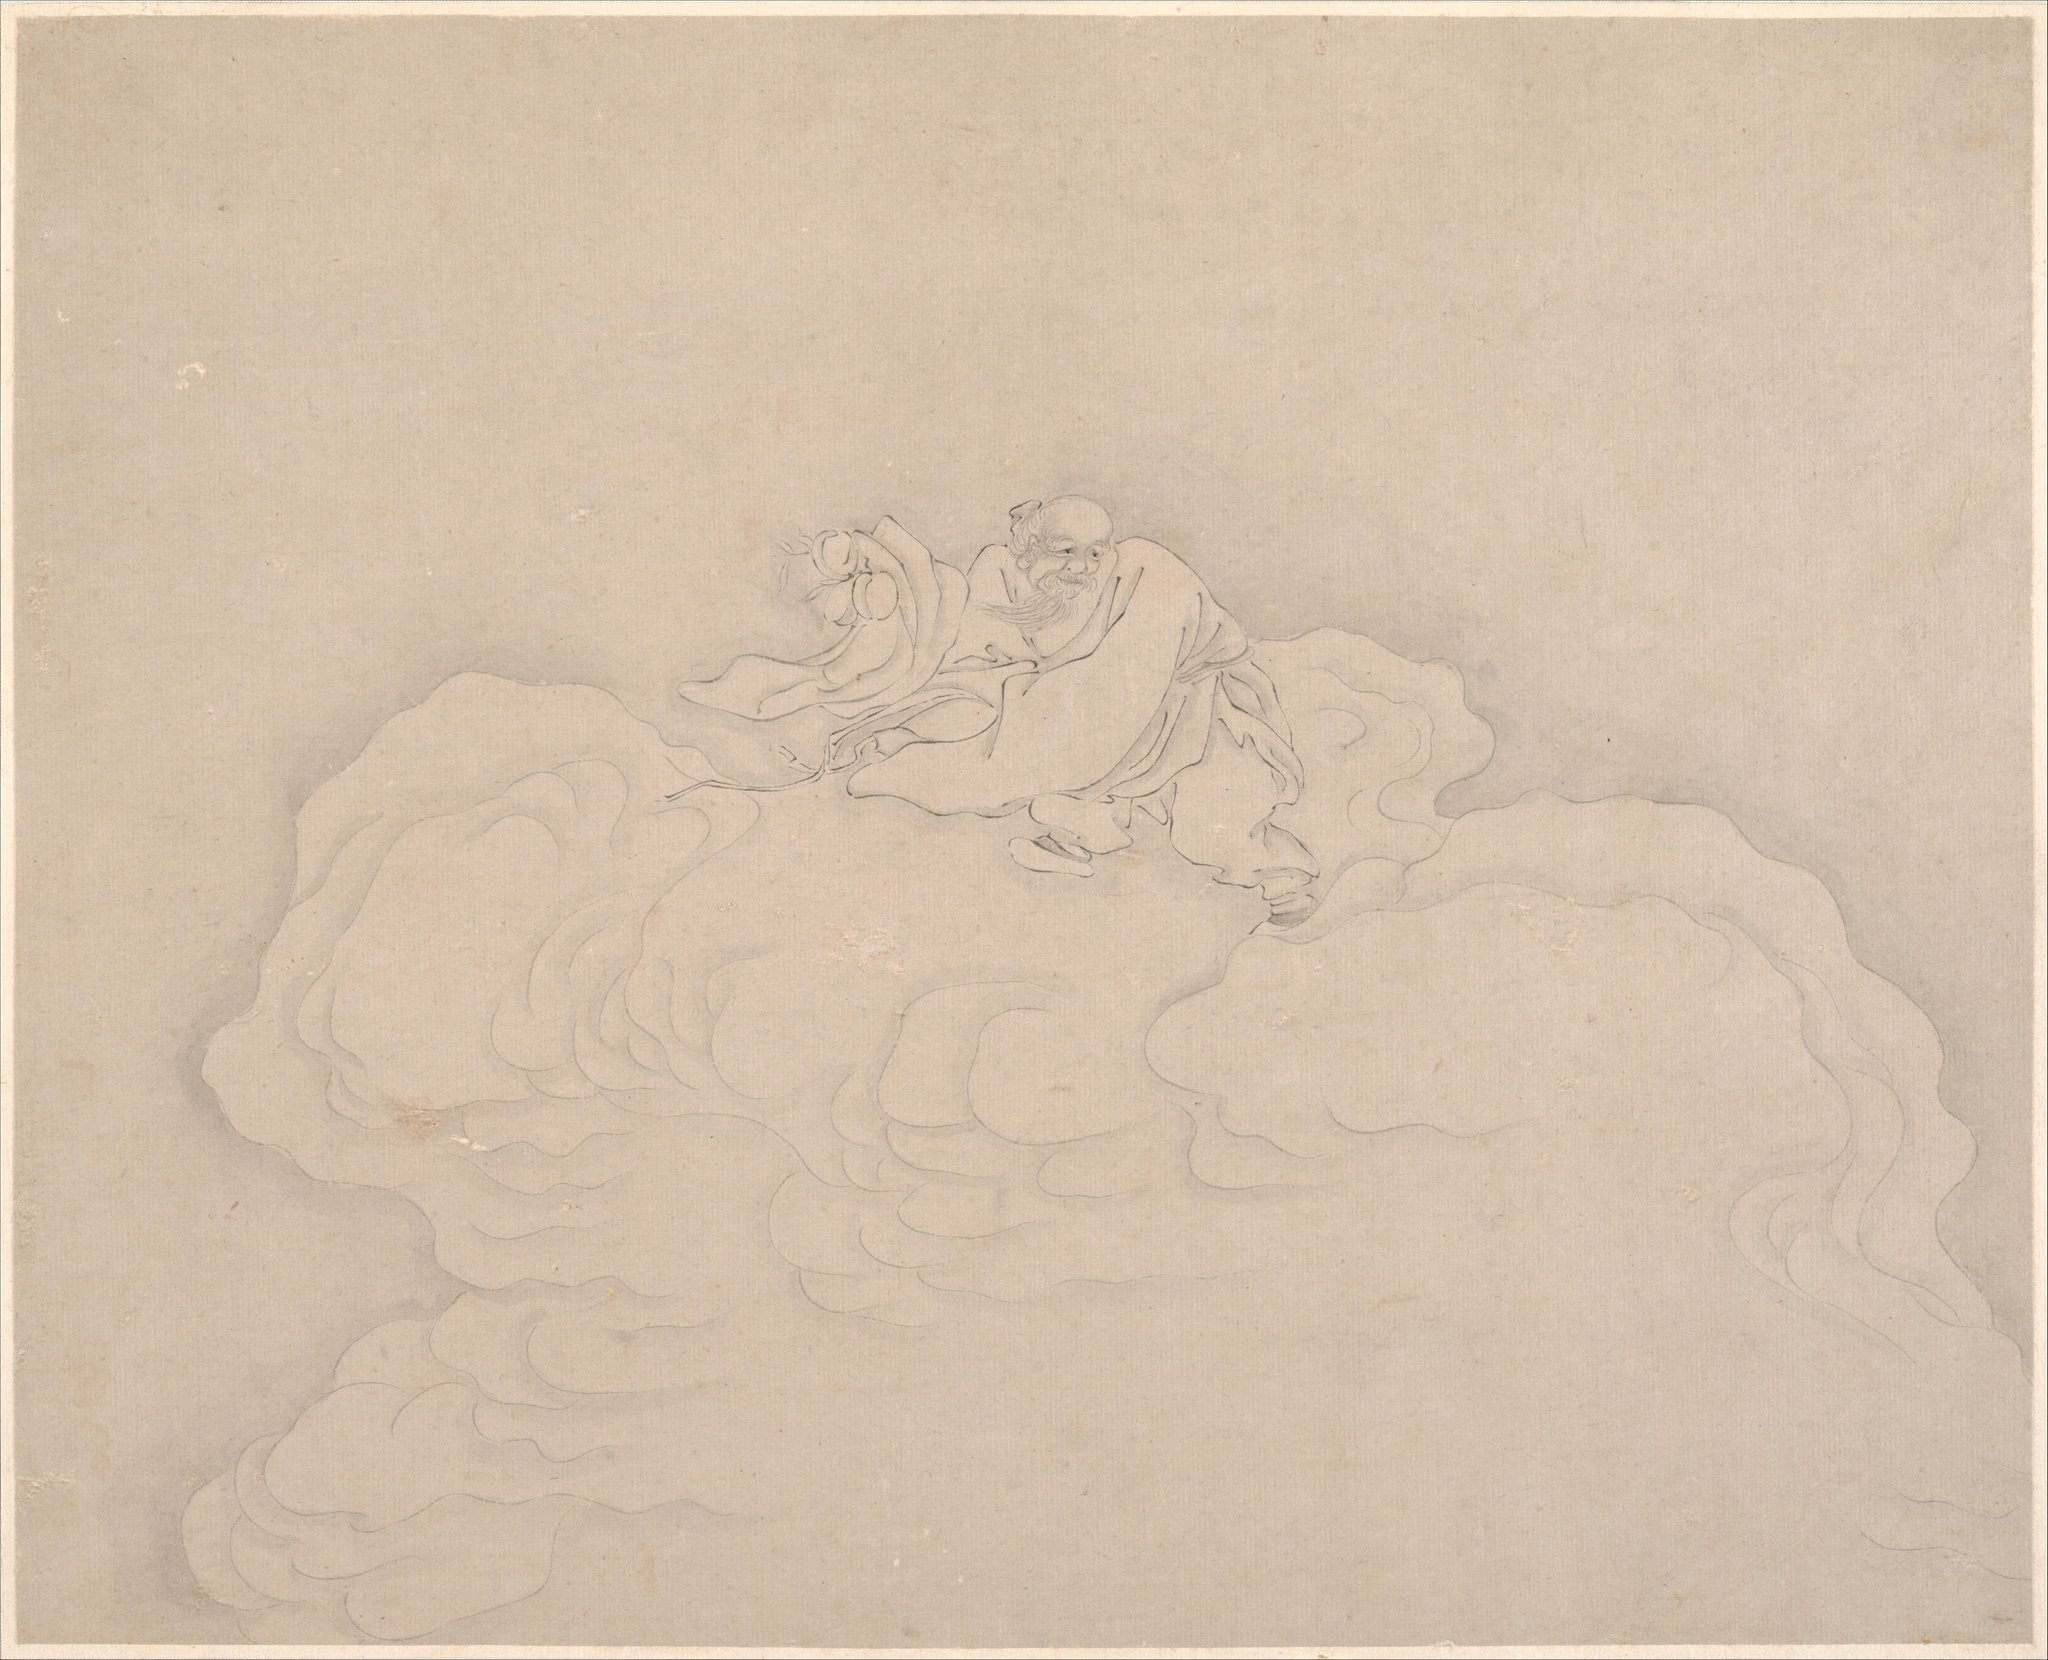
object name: album leaf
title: An Immortal on a Cloud with a Pair of Peaches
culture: chinese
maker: unidentified artist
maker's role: artist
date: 1901-2000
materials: ink, paper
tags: peaches,men,clouds